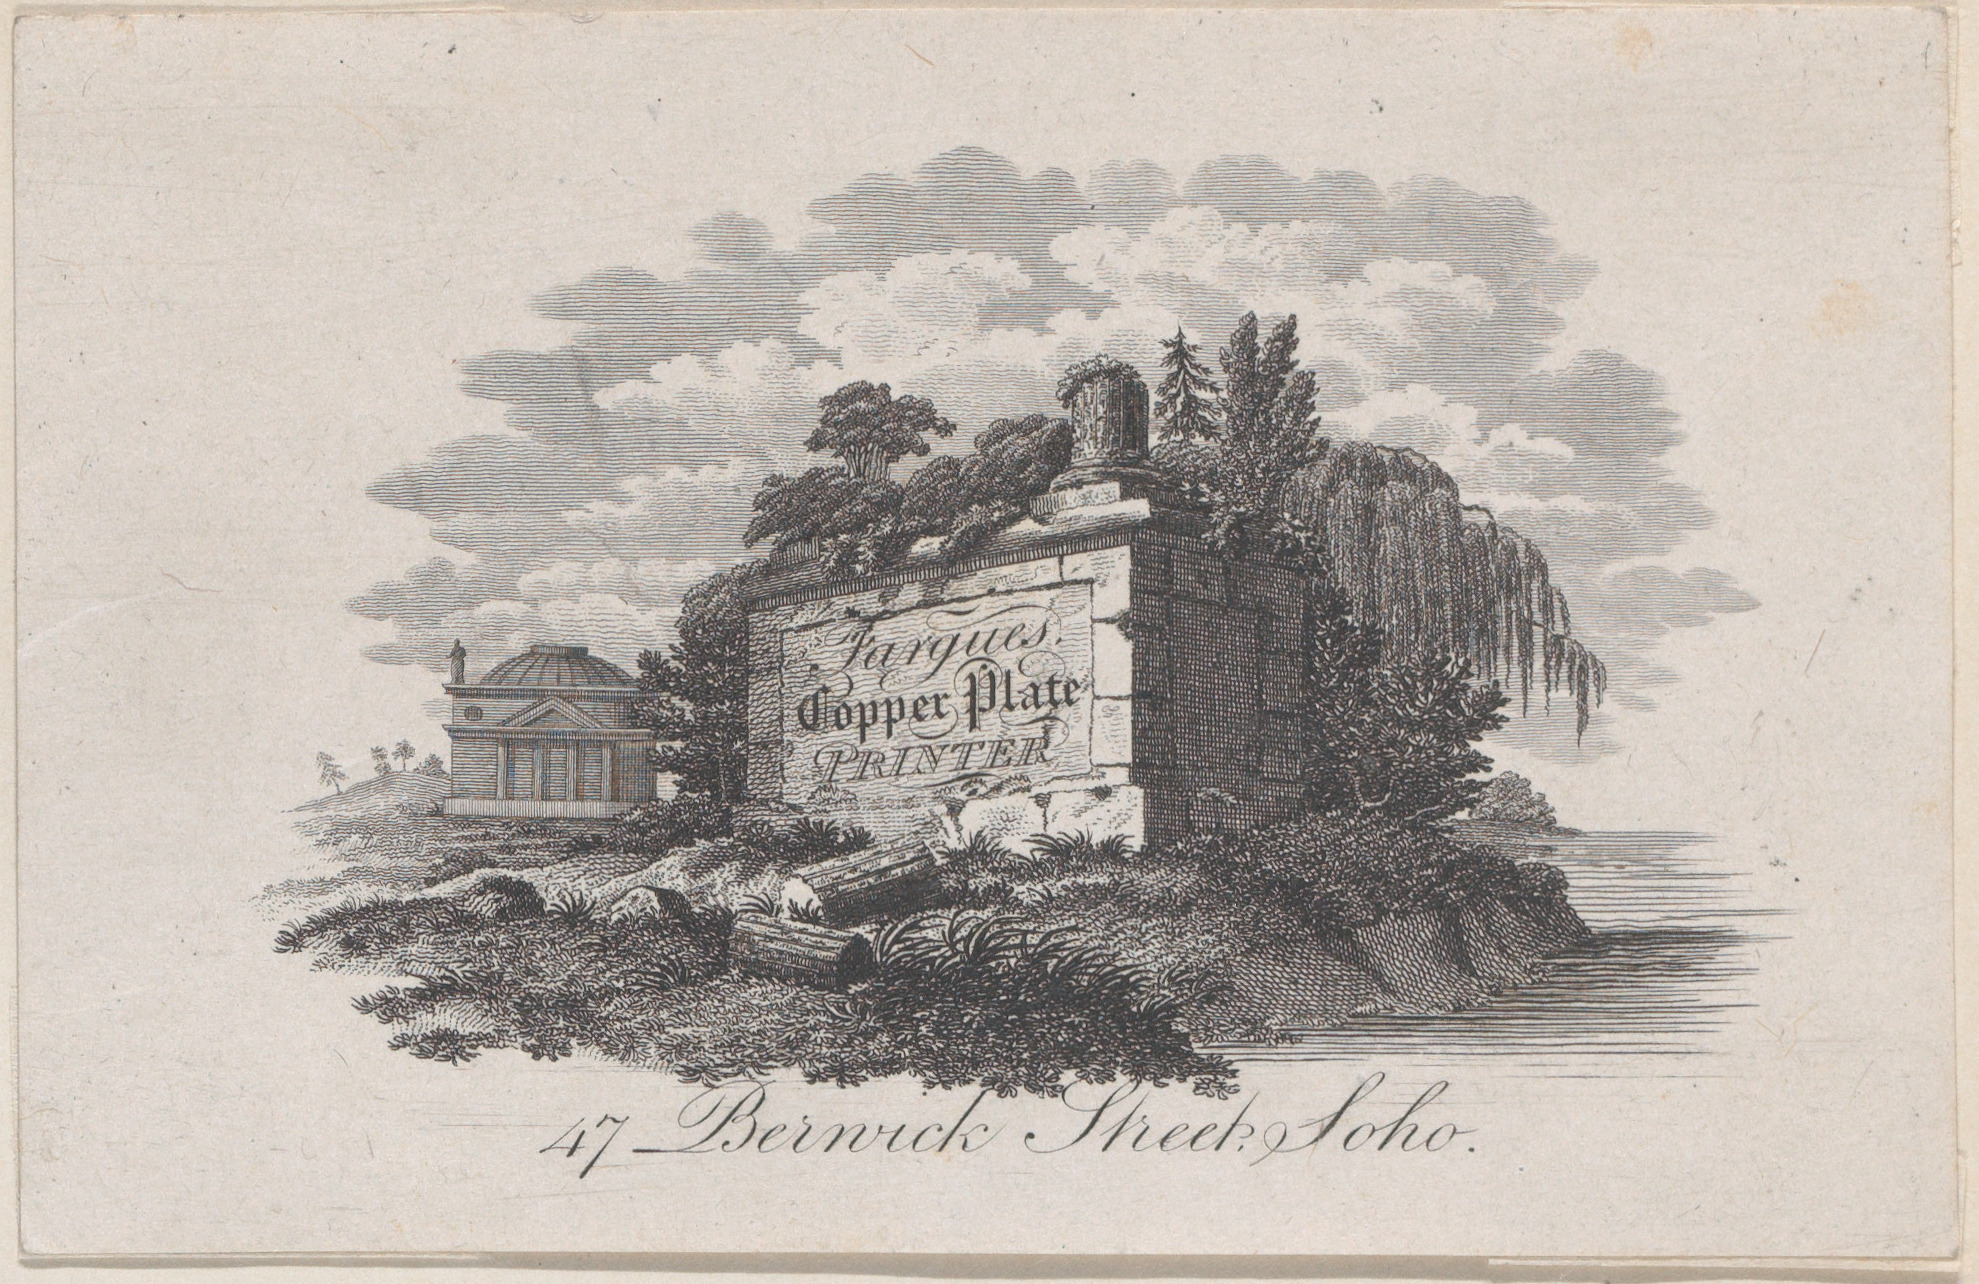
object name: print, trade card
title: Trade Card for F.P. Fargues, Copper Plate Printer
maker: anonymous, british, 18th century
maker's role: artist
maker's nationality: british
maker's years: 1700-1800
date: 1701-1800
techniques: engraving